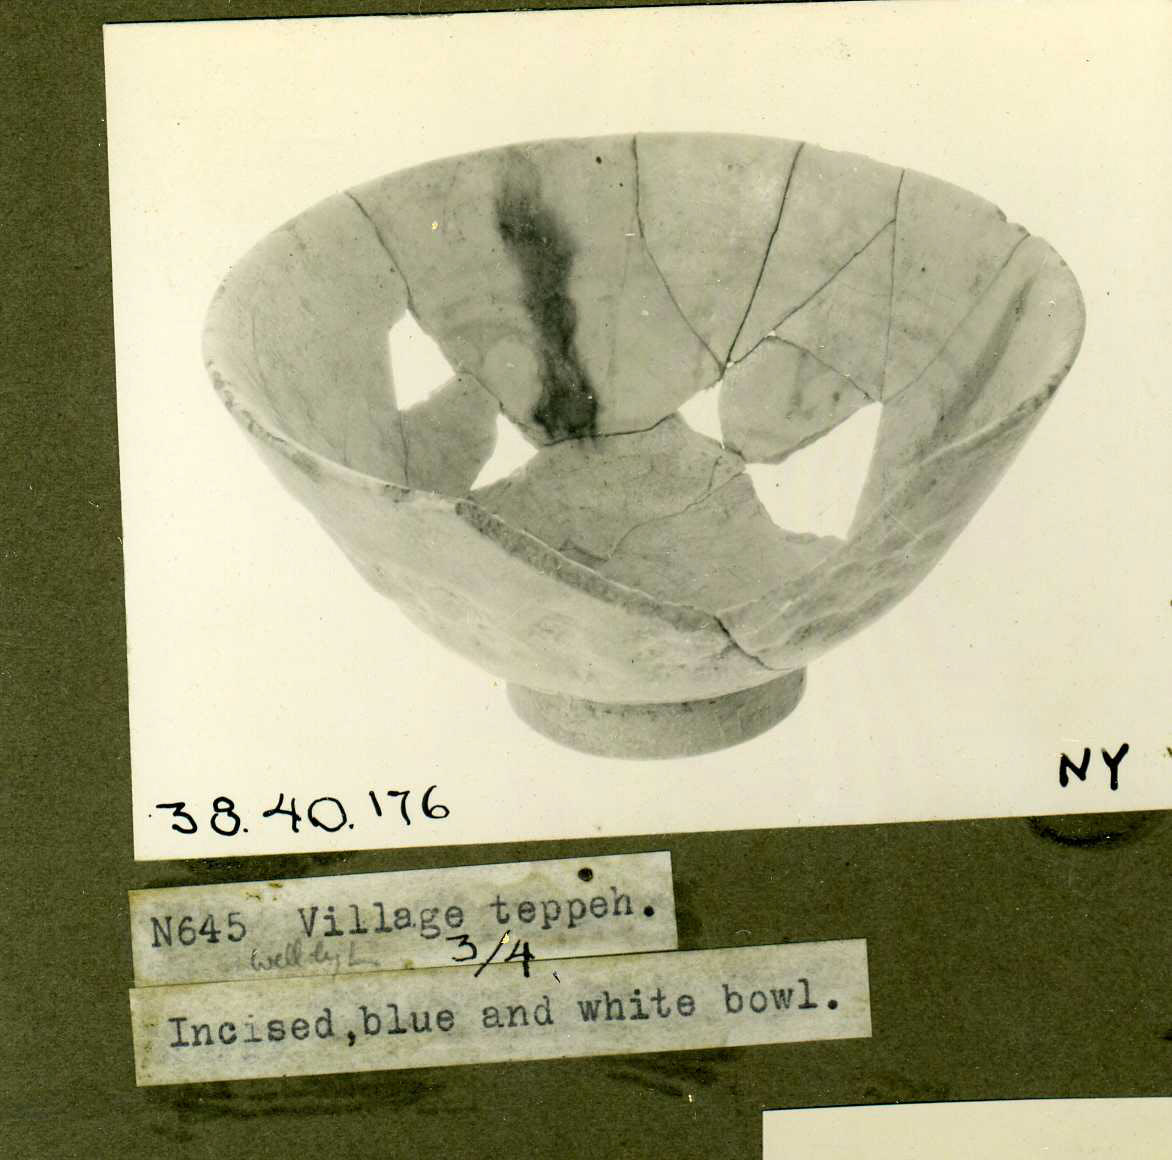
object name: bowl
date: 1001-1100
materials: earthenware, glaze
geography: iran